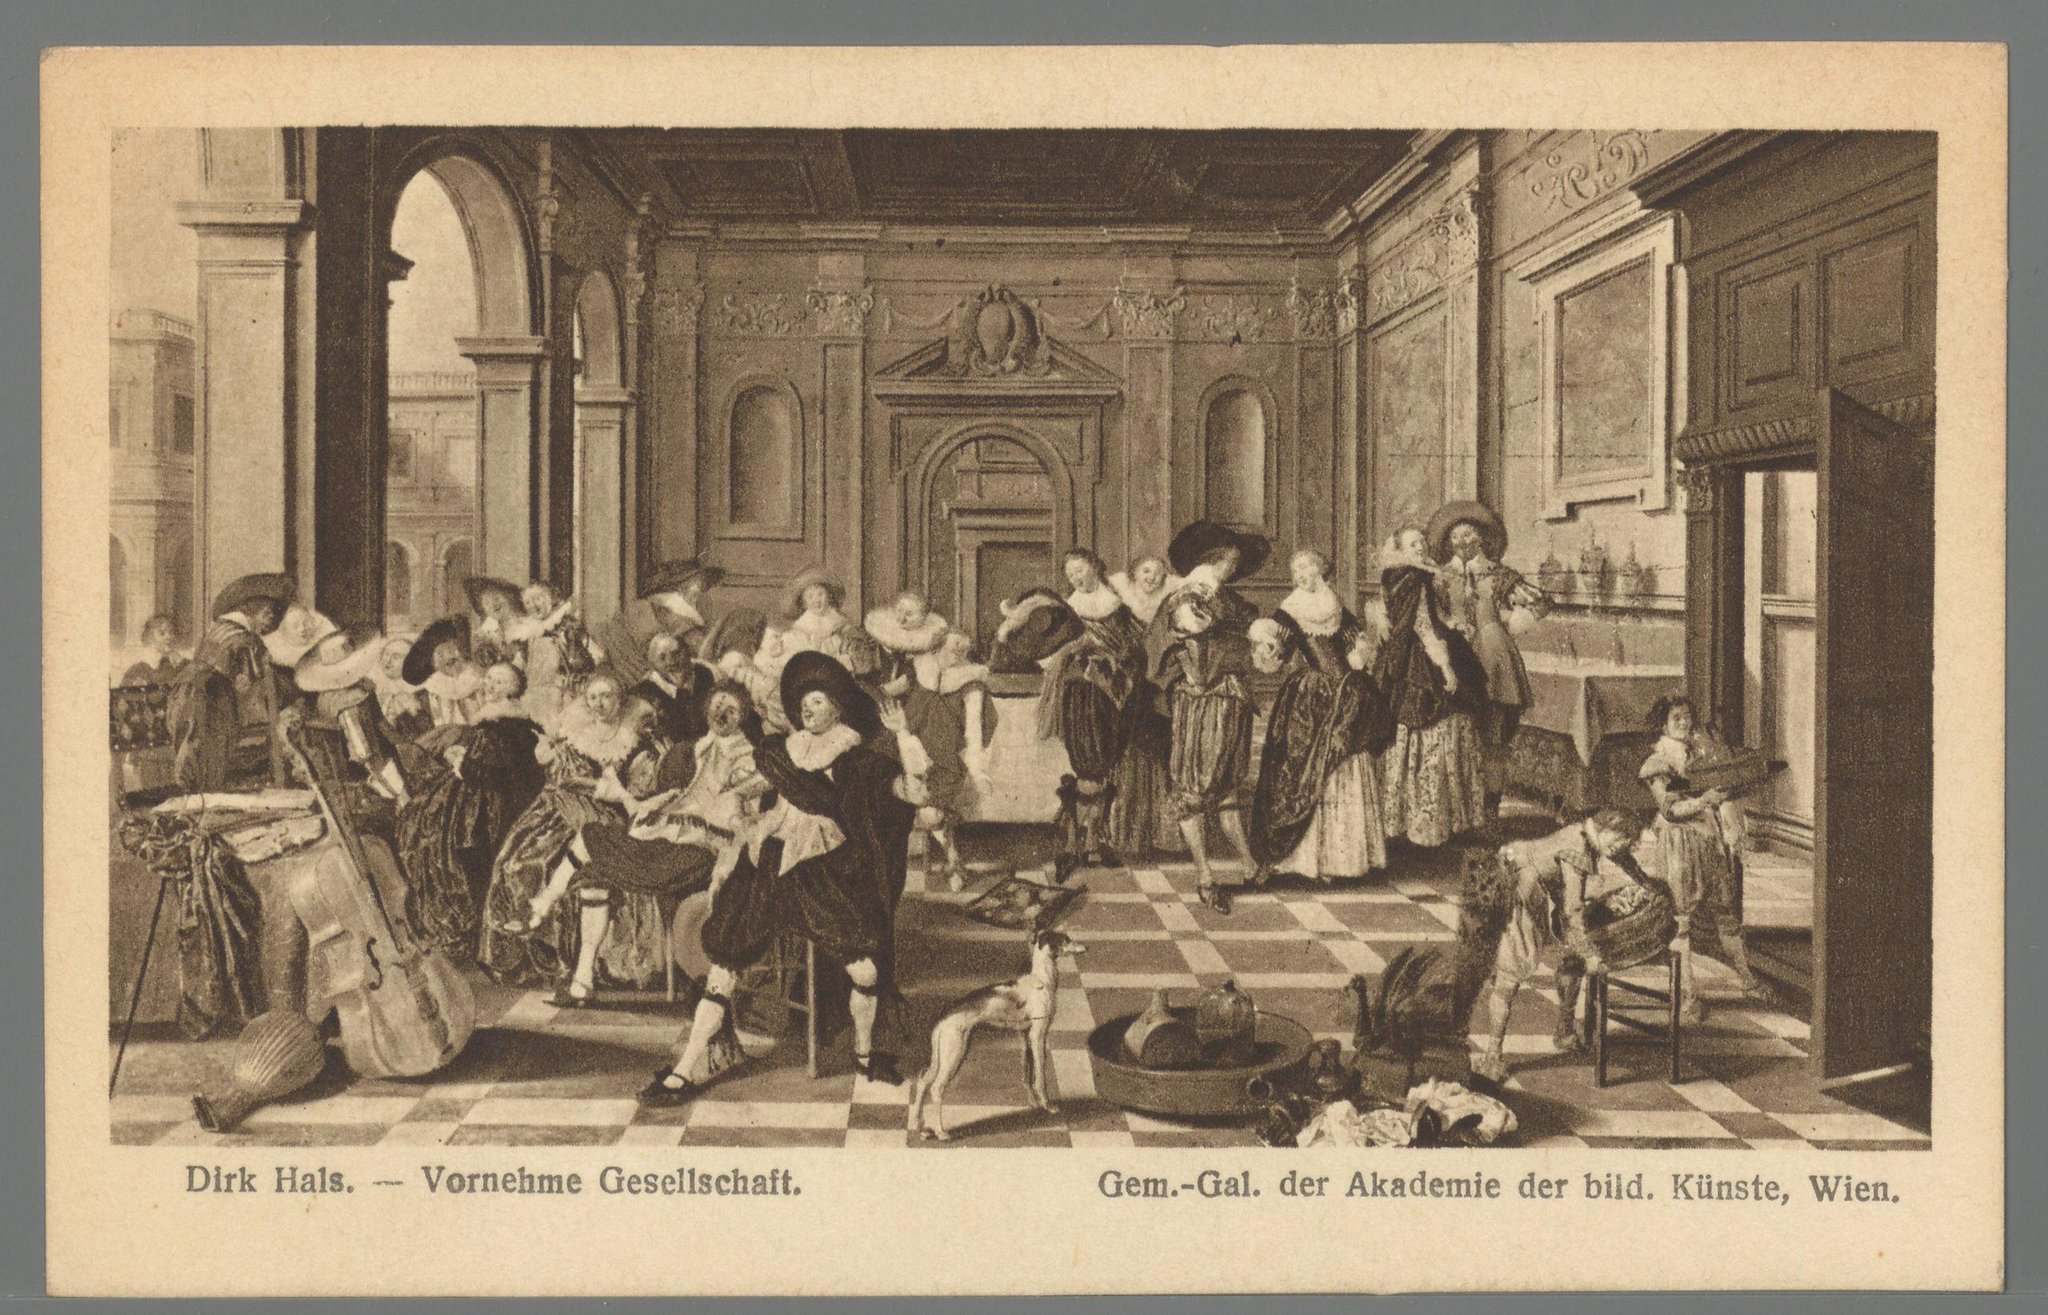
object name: ansichtkaart, prentbriefkaart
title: Dirk Hals. Vornehme Gesellschaft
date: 1905-1930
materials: cardboard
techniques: rotogravure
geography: vienna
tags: recreation, amusement, interior ~ representation of a building